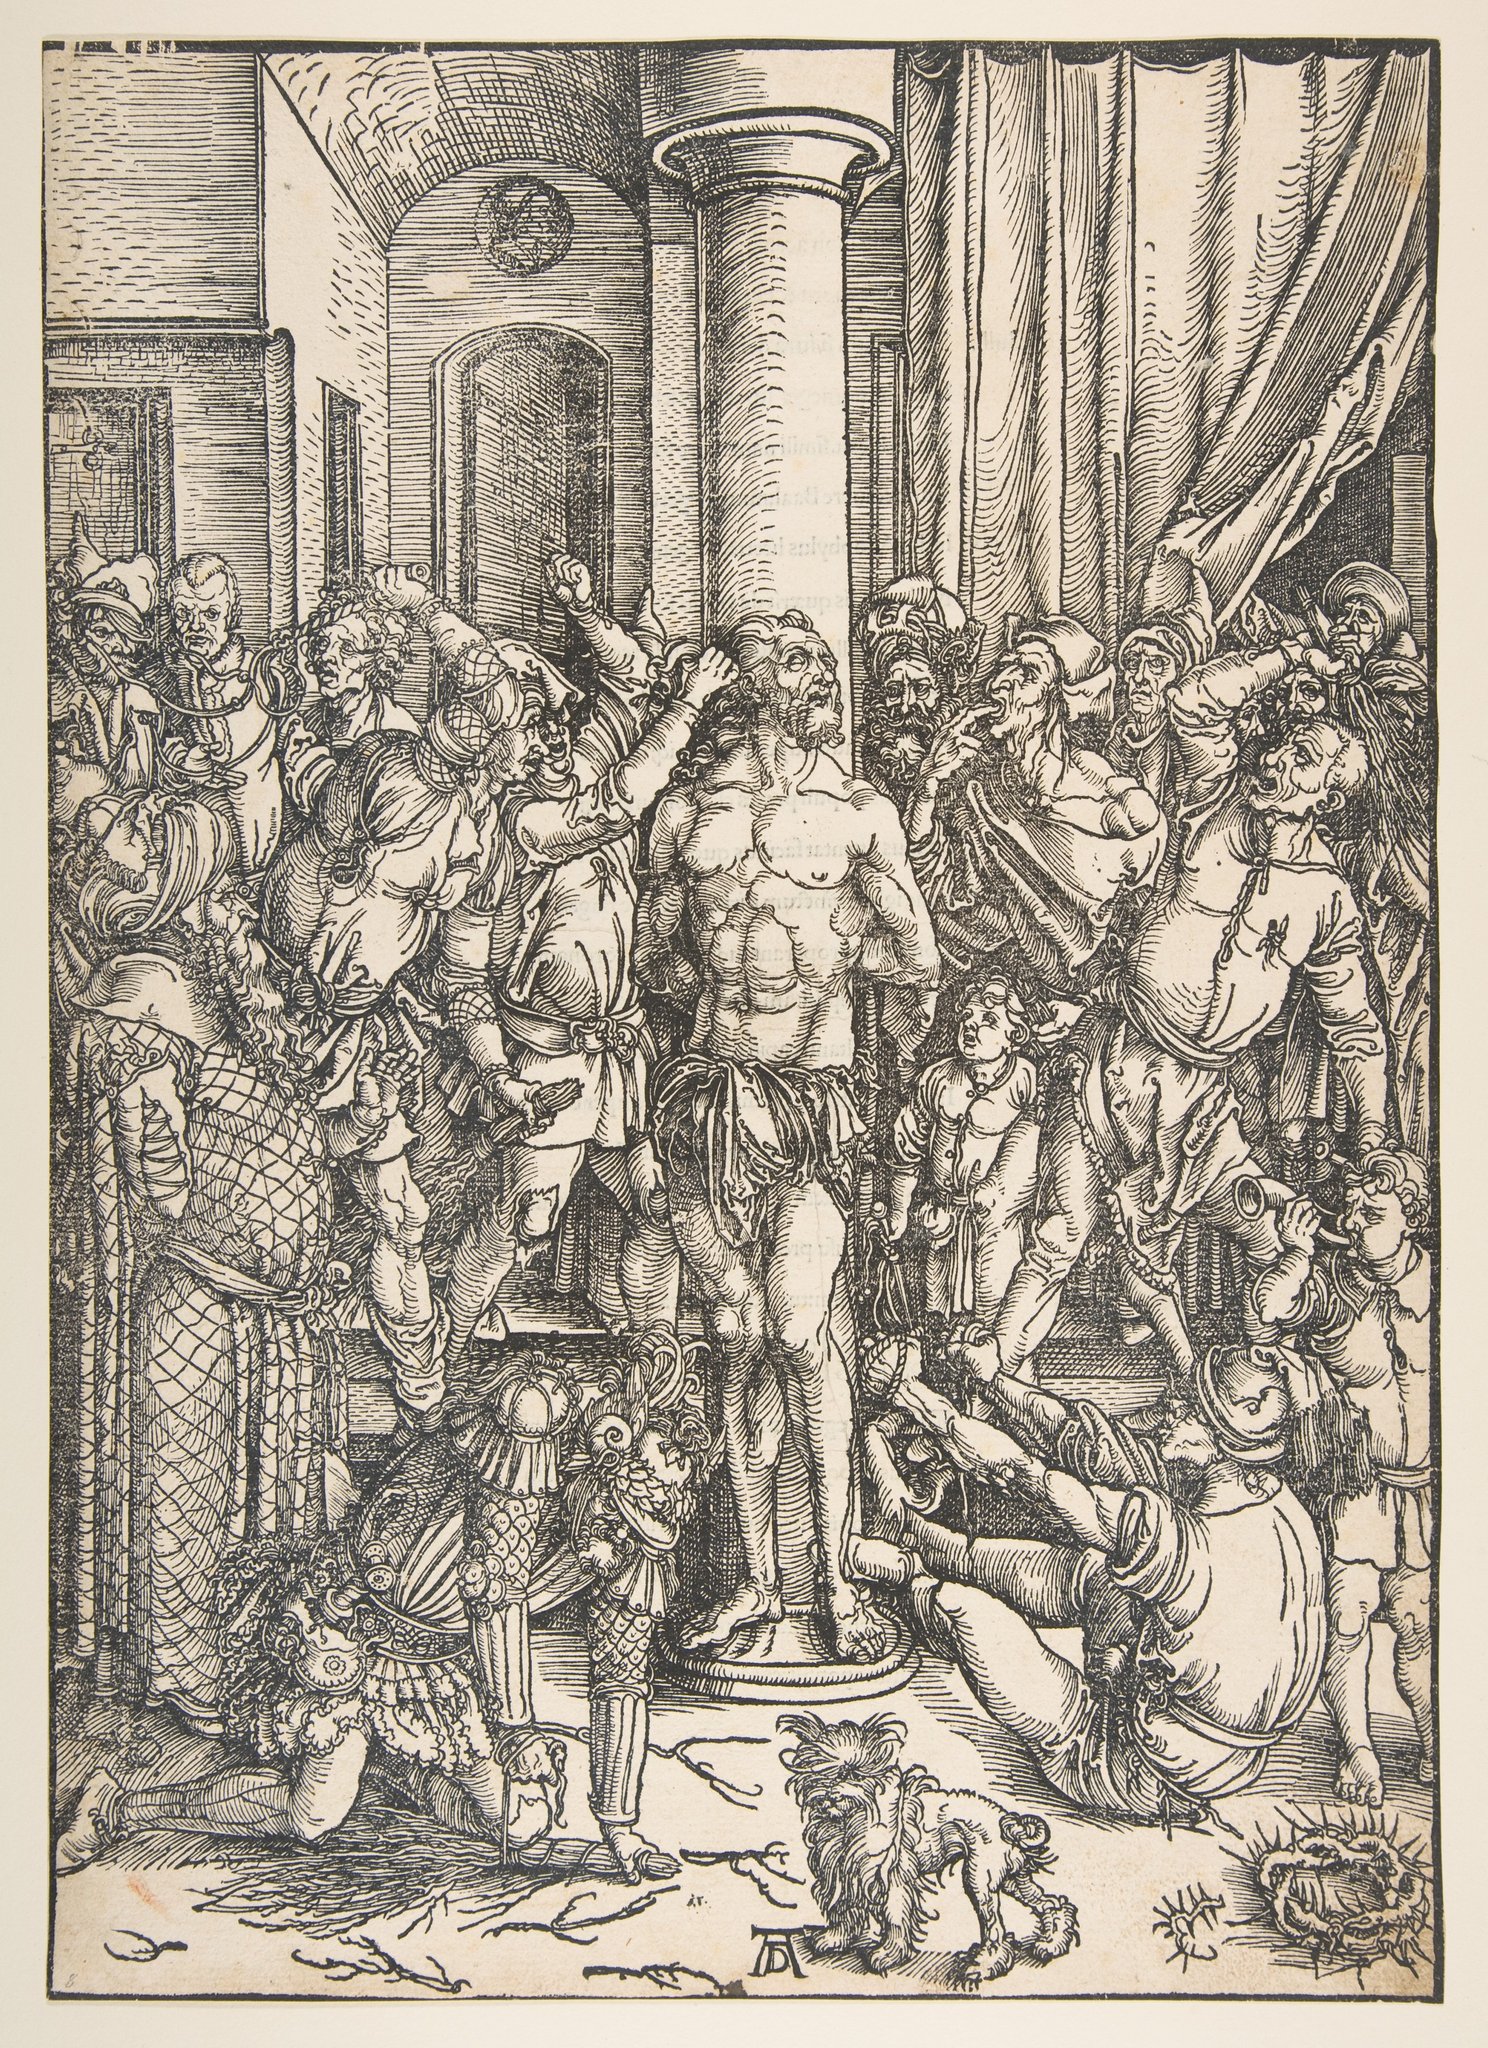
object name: print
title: The Scourging of Christ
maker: albrecht dürer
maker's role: artist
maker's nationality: german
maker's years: 1471-1528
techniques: woodcut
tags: animals,children,men,christ